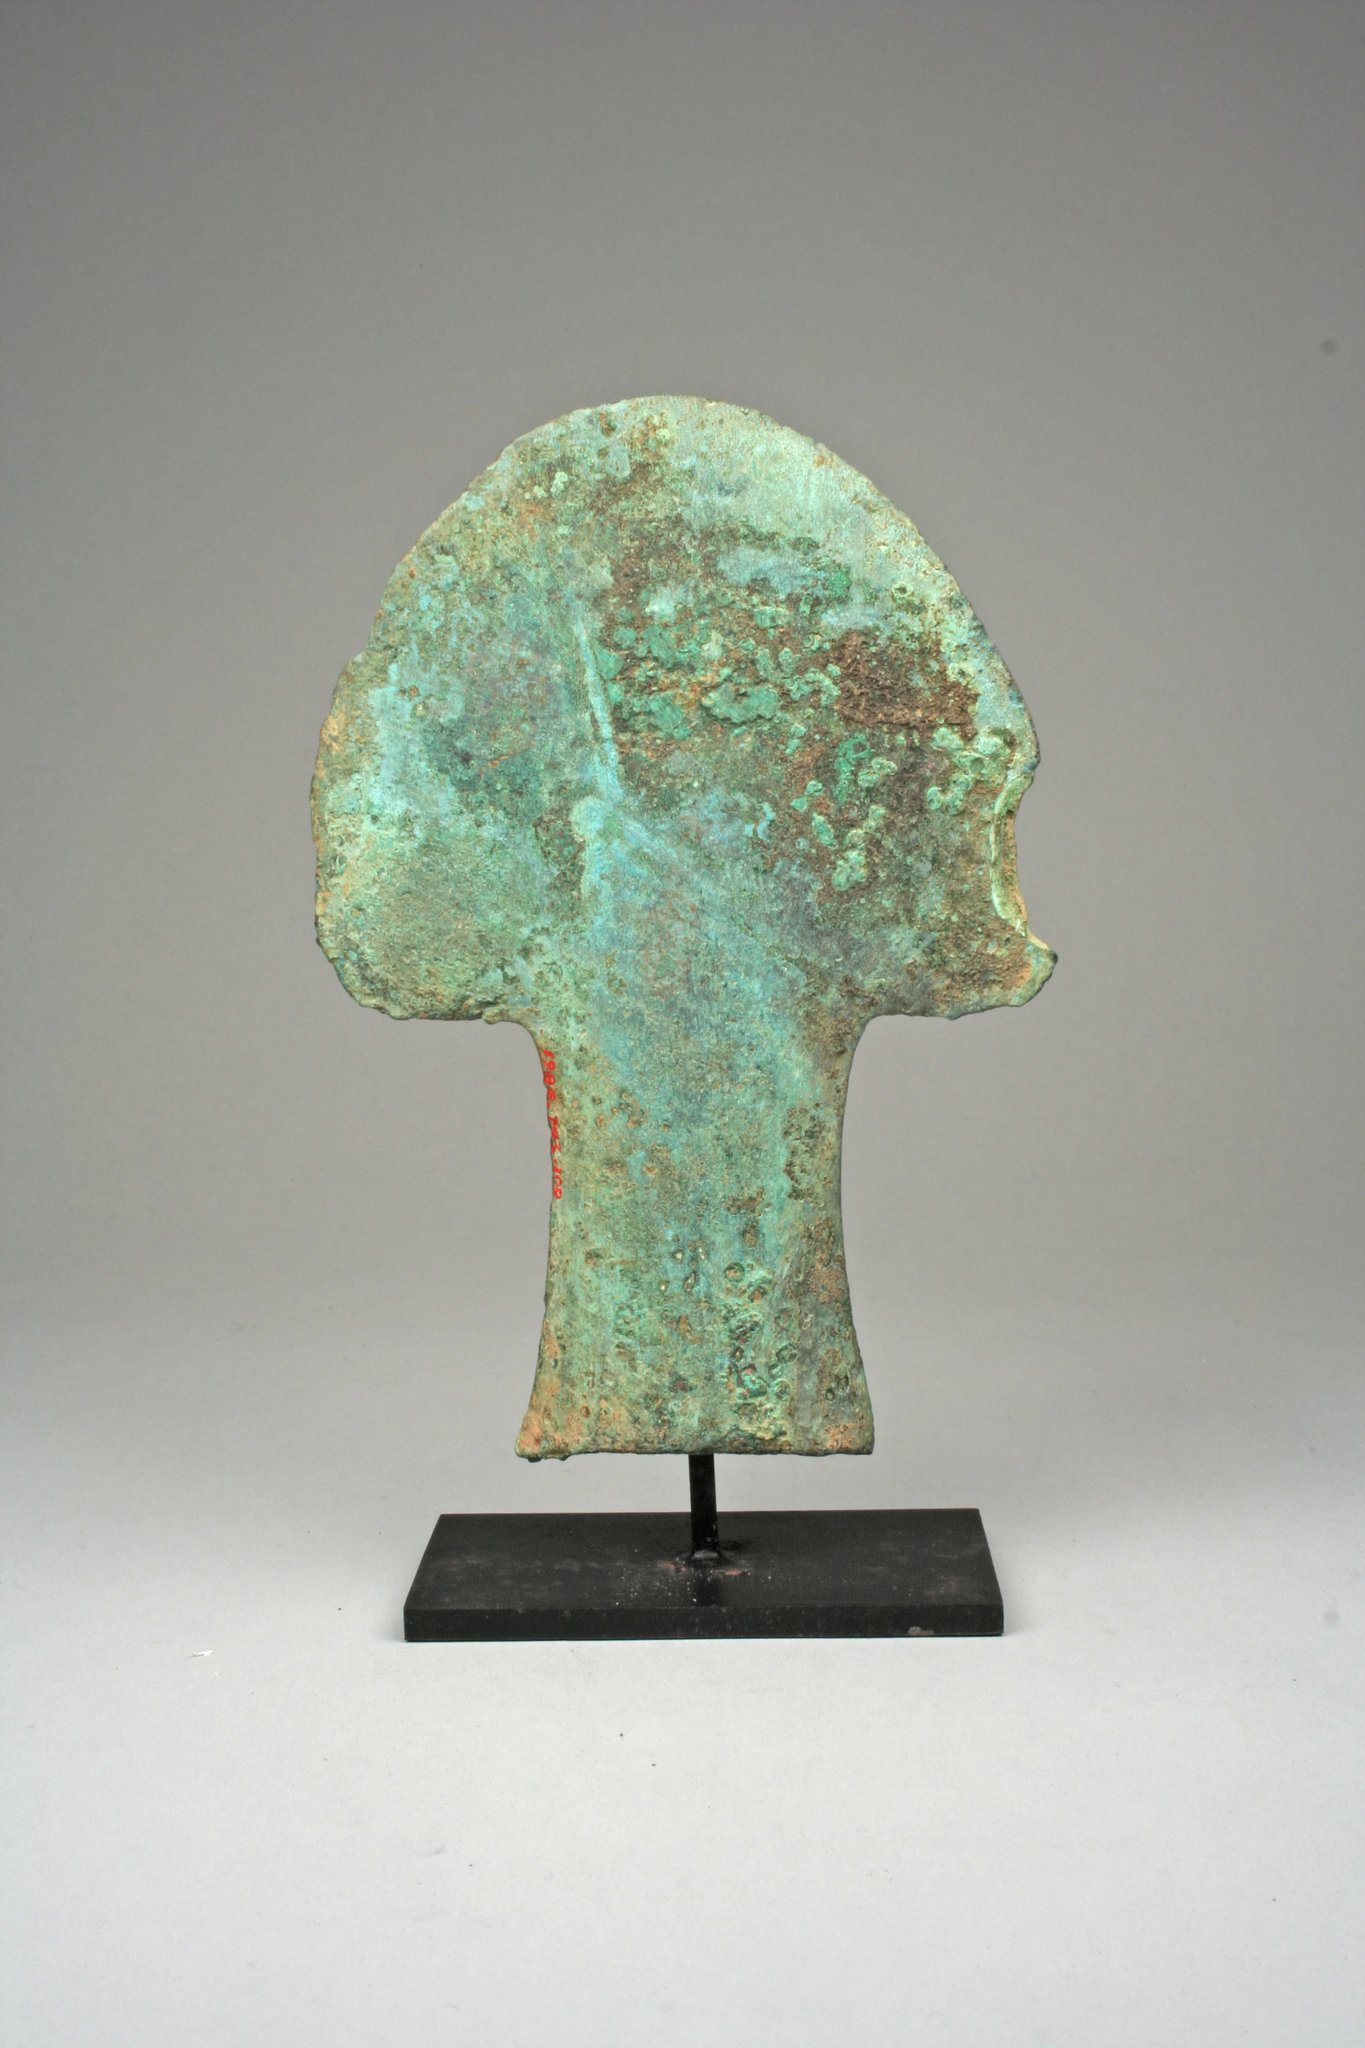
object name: axe blade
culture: dongson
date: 500 BCE-300 CE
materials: bronze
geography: indonesia